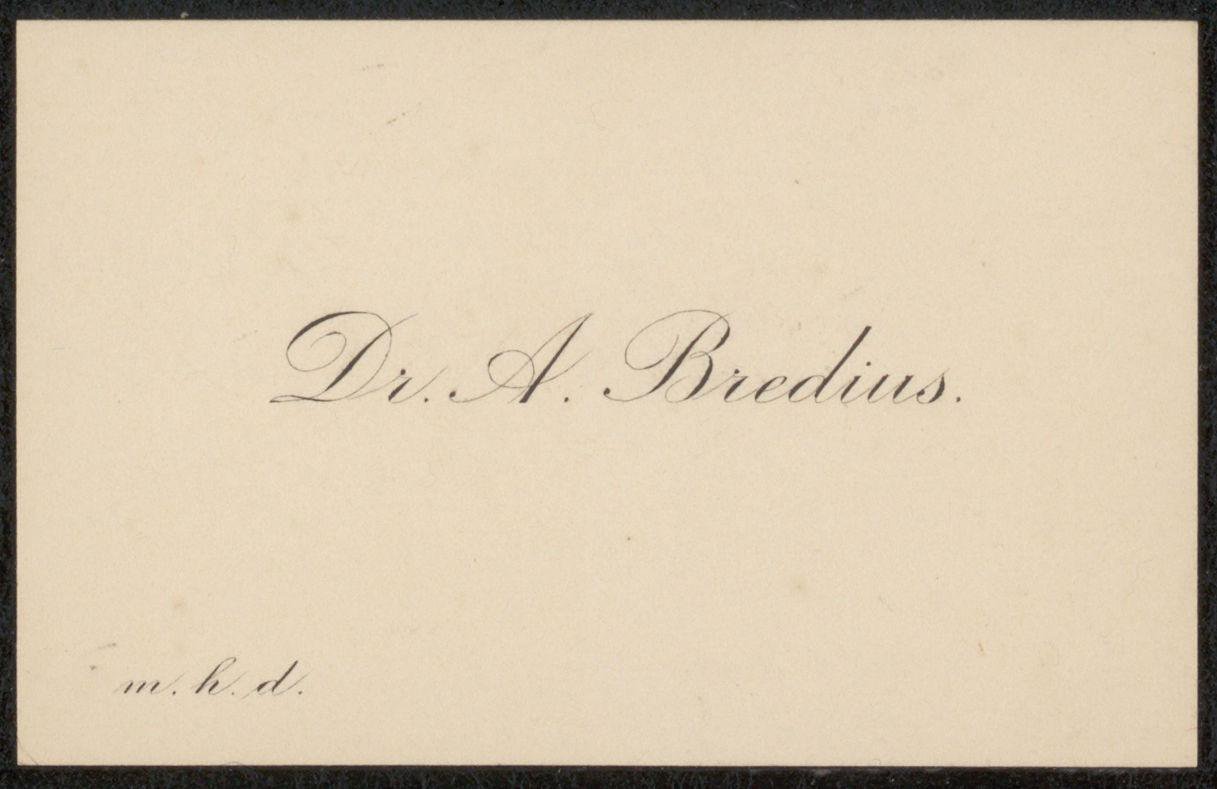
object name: visiting card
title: Visitekaartje aan Philip Zilcken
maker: Anonymous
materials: cardboard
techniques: printing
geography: netherlands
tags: amsterdam, abraham bredius, the hague, painter, draughtsman, philip zilcken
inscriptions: collector's mark: ‘RPK’